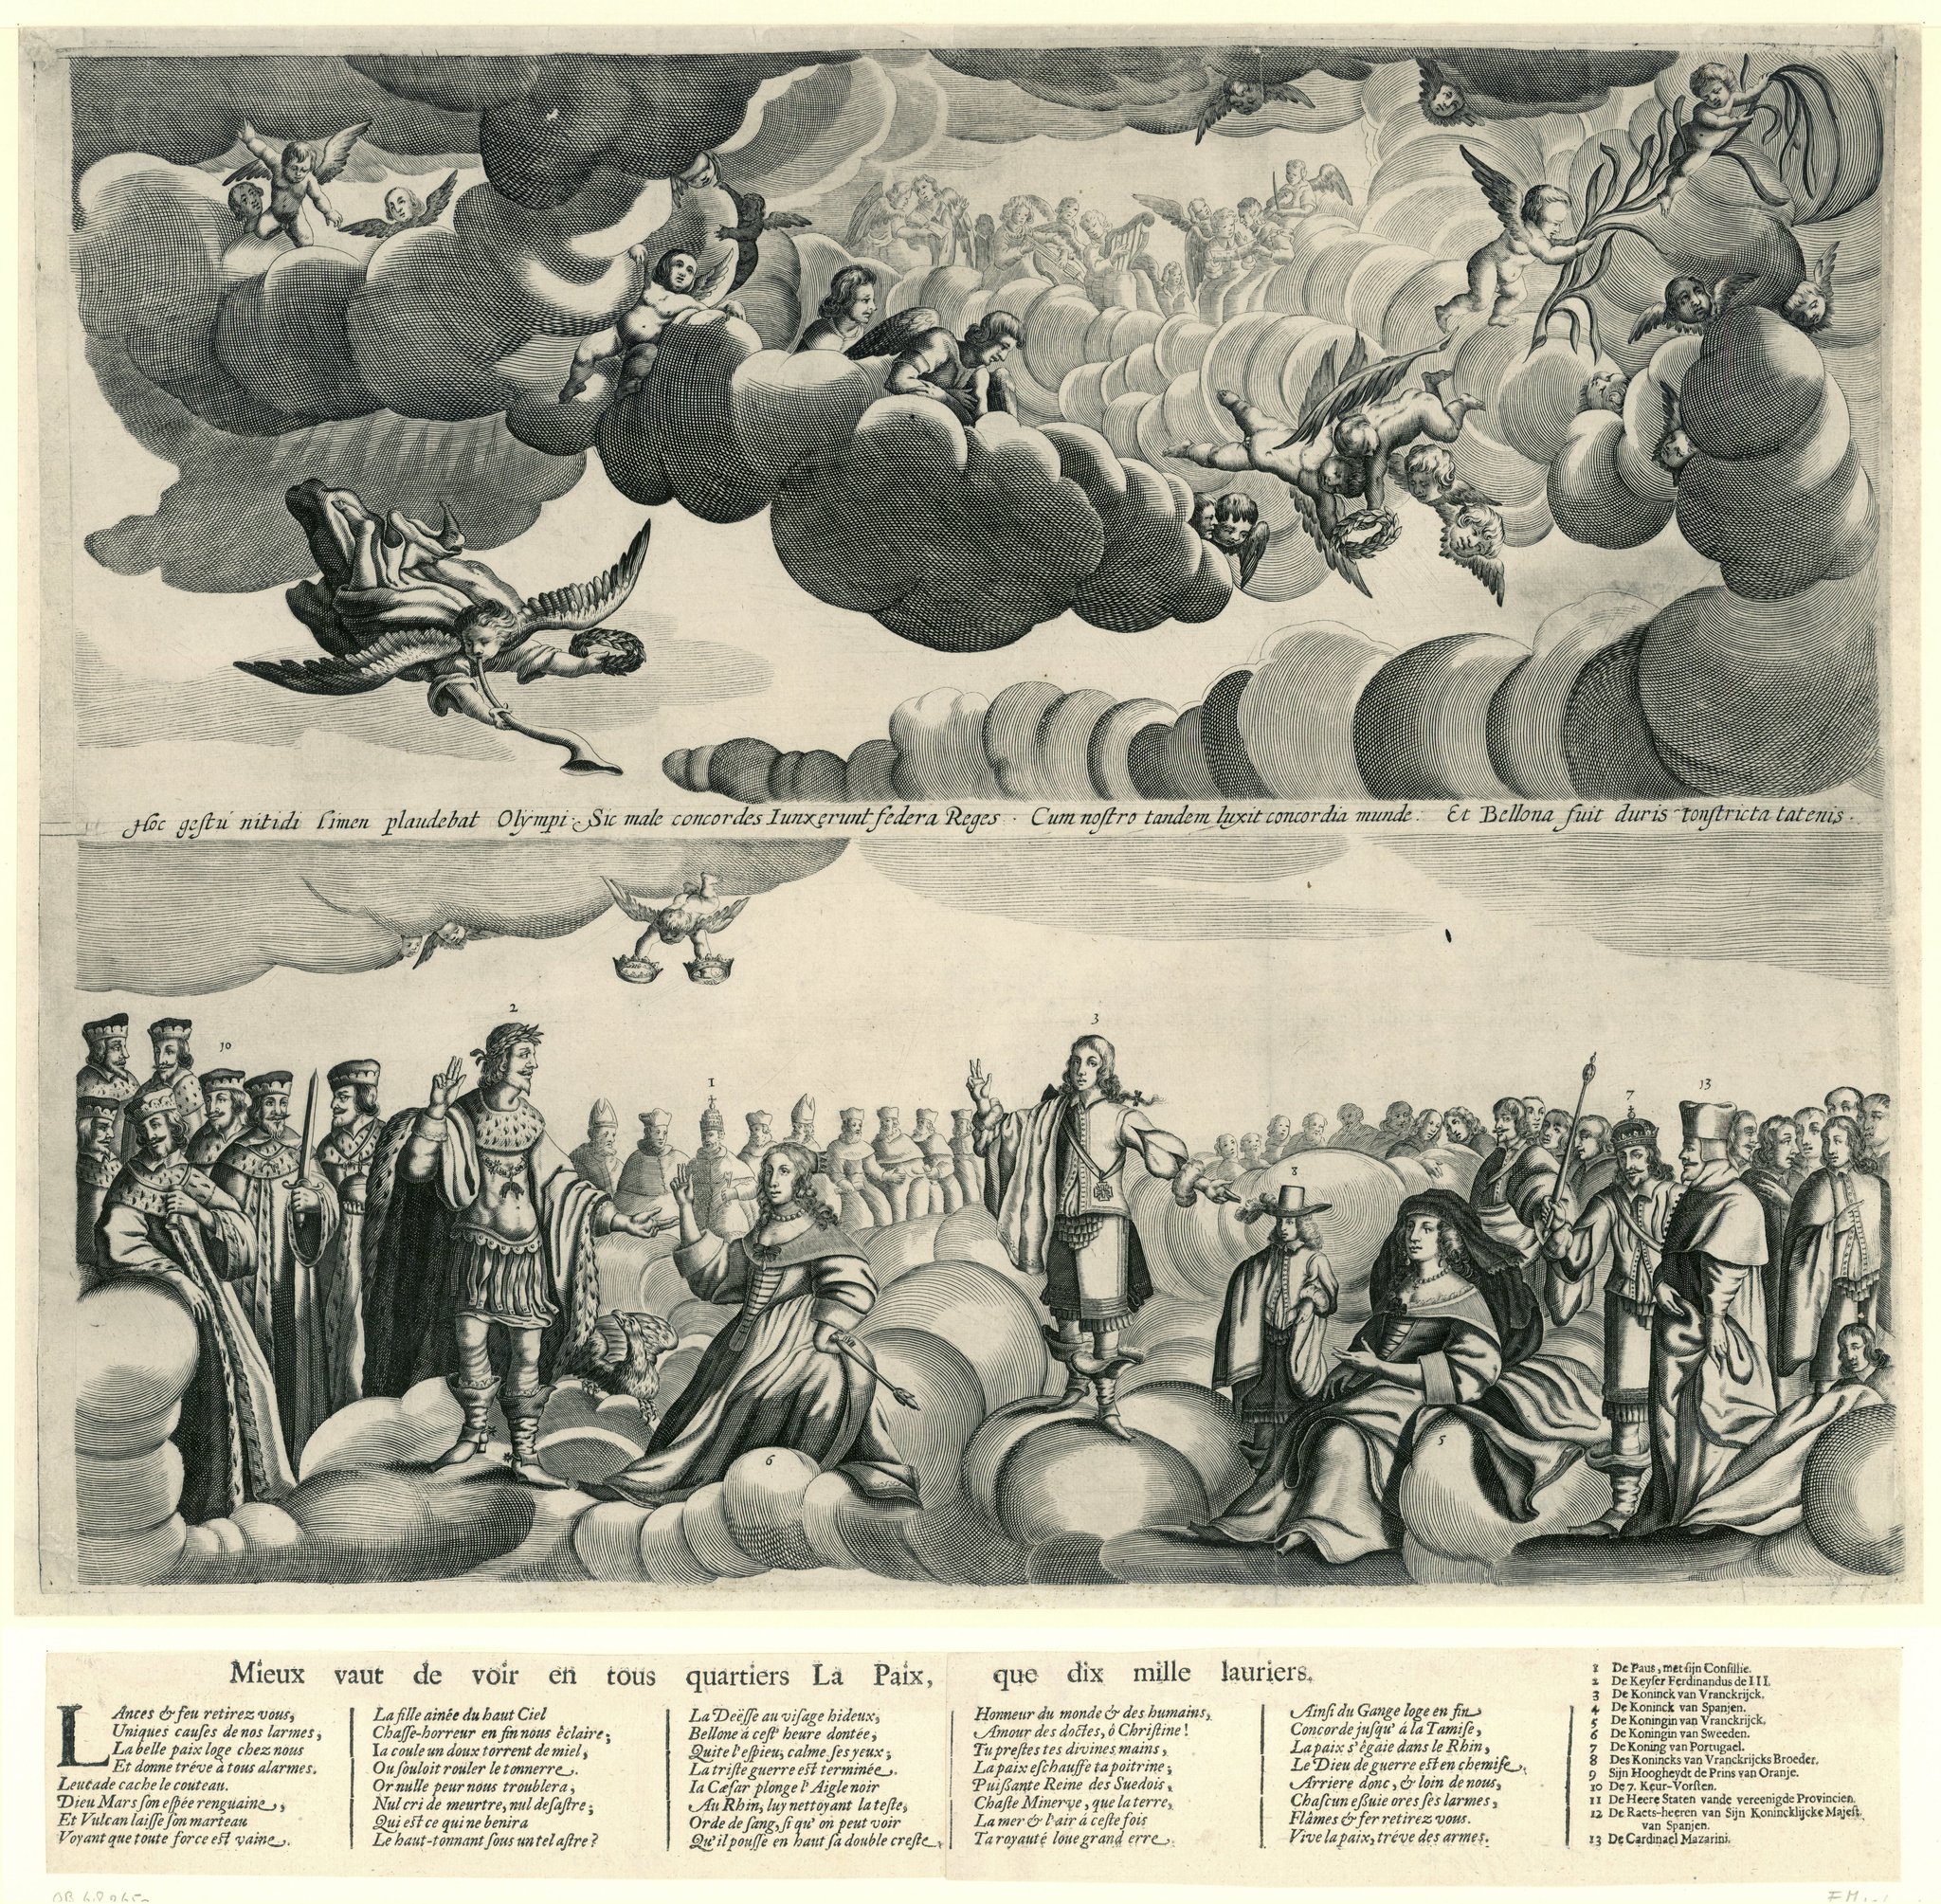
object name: print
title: Allegorie op de Vrede van Westfalen (linkerblad), 1648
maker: Anonymous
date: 1648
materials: paper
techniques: engraving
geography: low countries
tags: anna van oostenrijk (koningin van frankrijk), rome, christina (koningin van zweden), vienna, ferdinand iii (duits keizer), lodewijk xiv (koning van frankrijk)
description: Allegorie op de Vrede van Westfalen (linkerblad), 1648. De voorstelling op het linkerblad toont boven de hemel met engelen en onder een groep vorsten in de wolken. Verschillende personen leggen een eed af. Door de wolken loopt een Latijnse tekst. Afgebeeld zijn onder andere: Lodewijk XIV, keizer Ferdinand III en koningin Christina van Zweden. Bij de prent behoort een tekstblad met een Franse vers in 5 kolommen en een legenda 1-13 in het Nederlands.